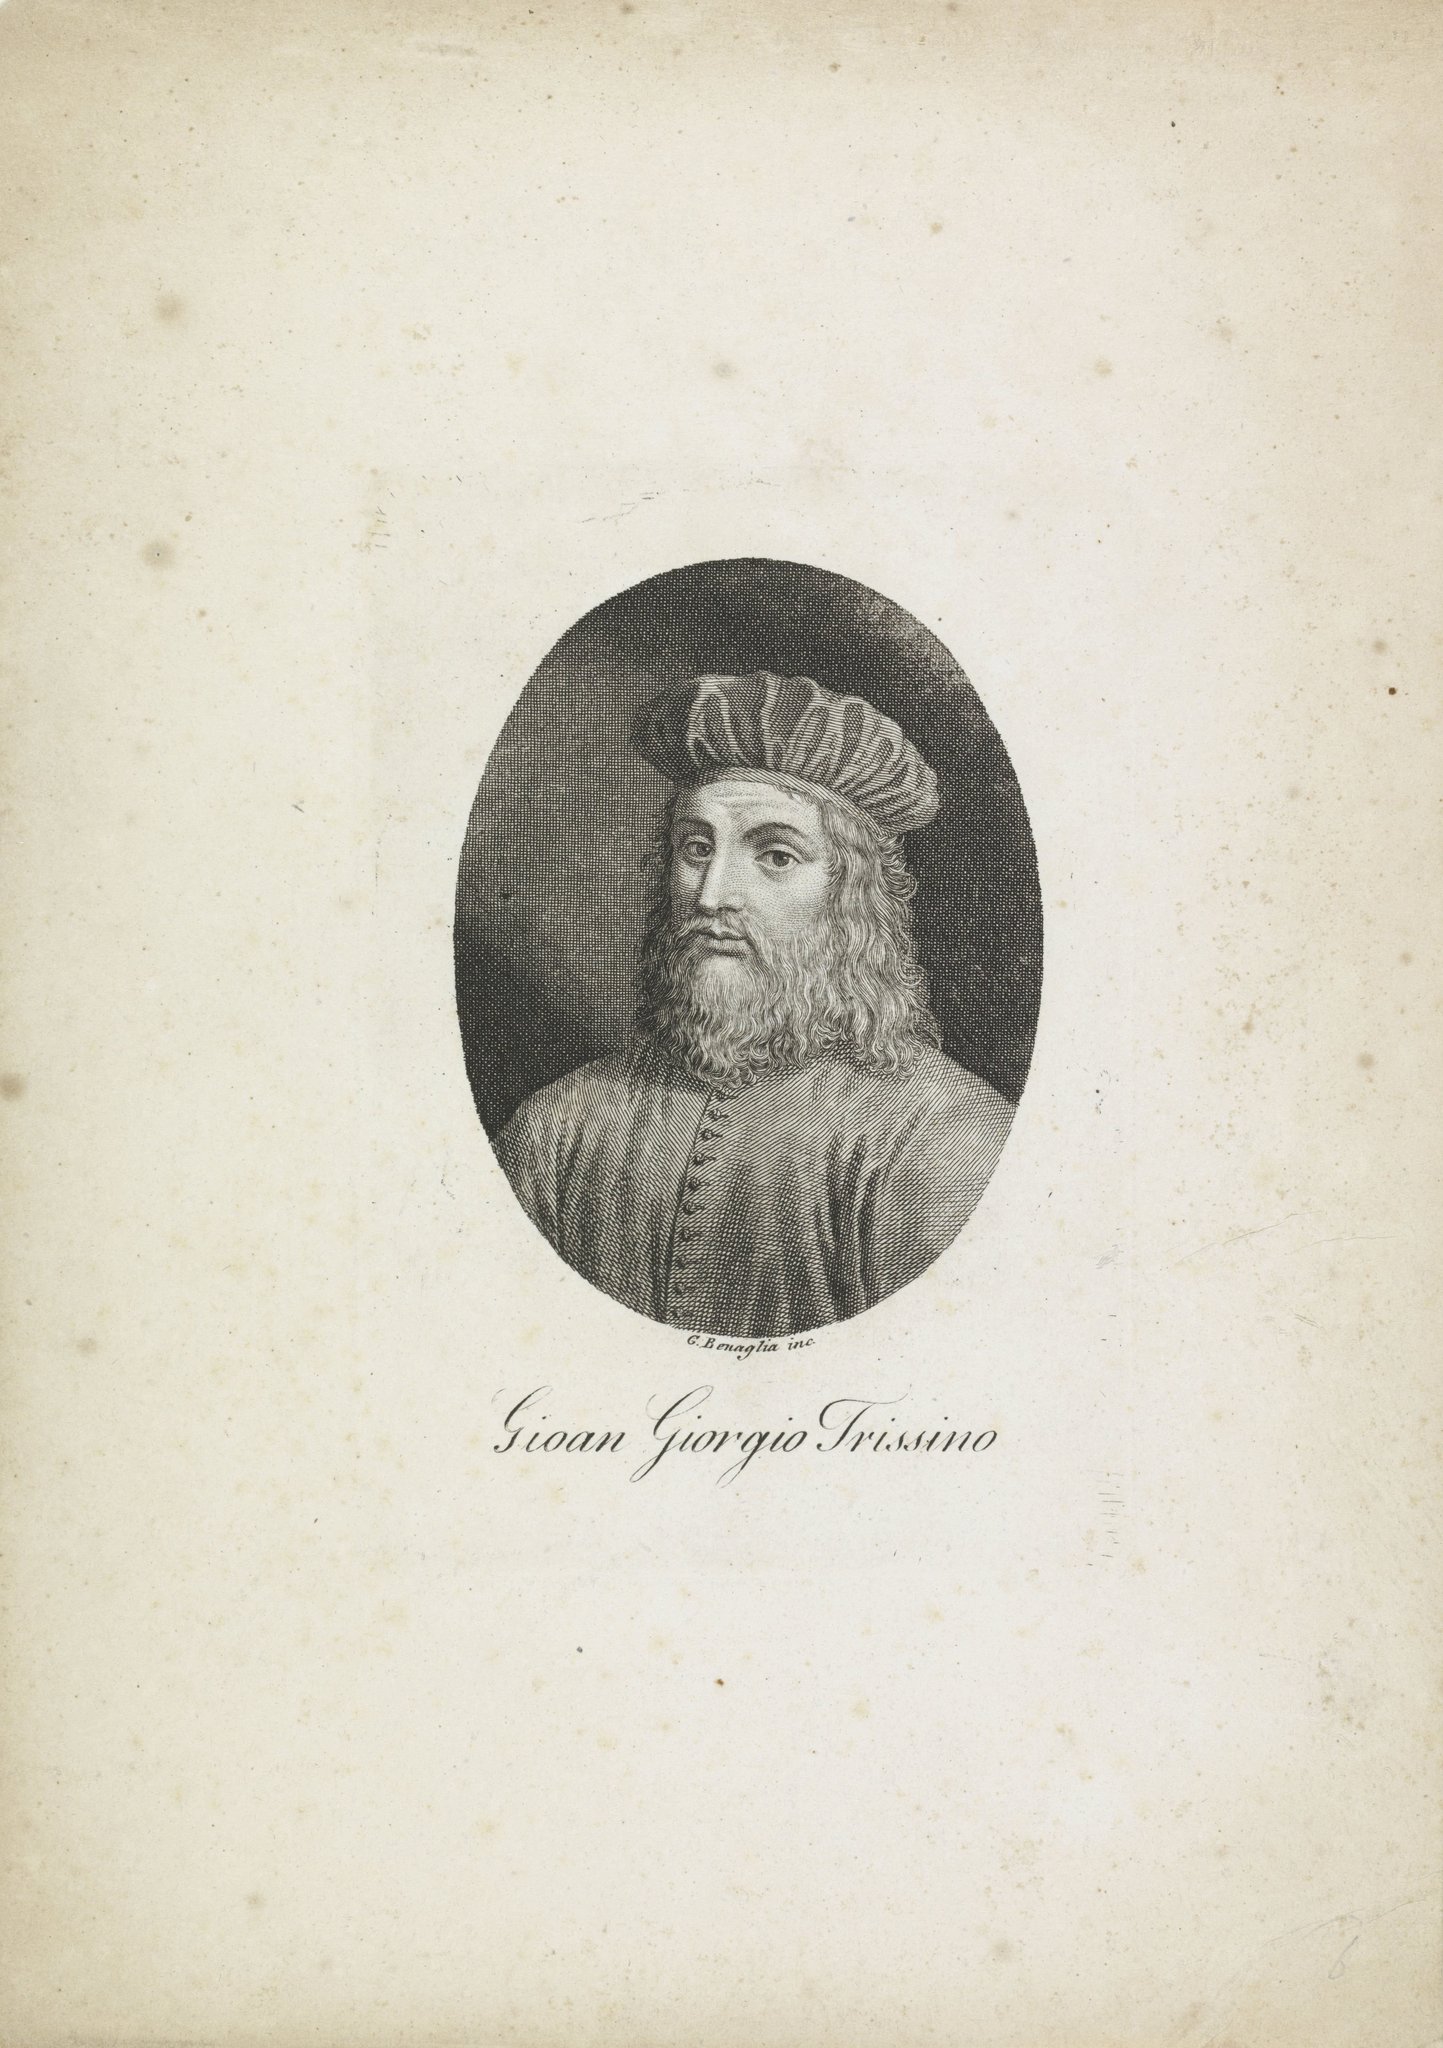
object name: print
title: Portret van humanist en diplomaat Gian Giorgio Trissino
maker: giuseppe benaglia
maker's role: print maker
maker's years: 1796-1830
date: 1806-1830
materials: paper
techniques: engraving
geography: italy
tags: rome, historical persons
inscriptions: collector's mark: Lugt 2228